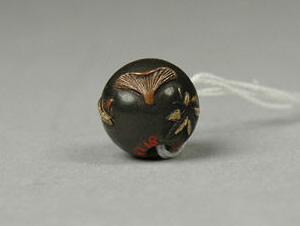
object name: ojime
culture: japanese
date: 1801-1900